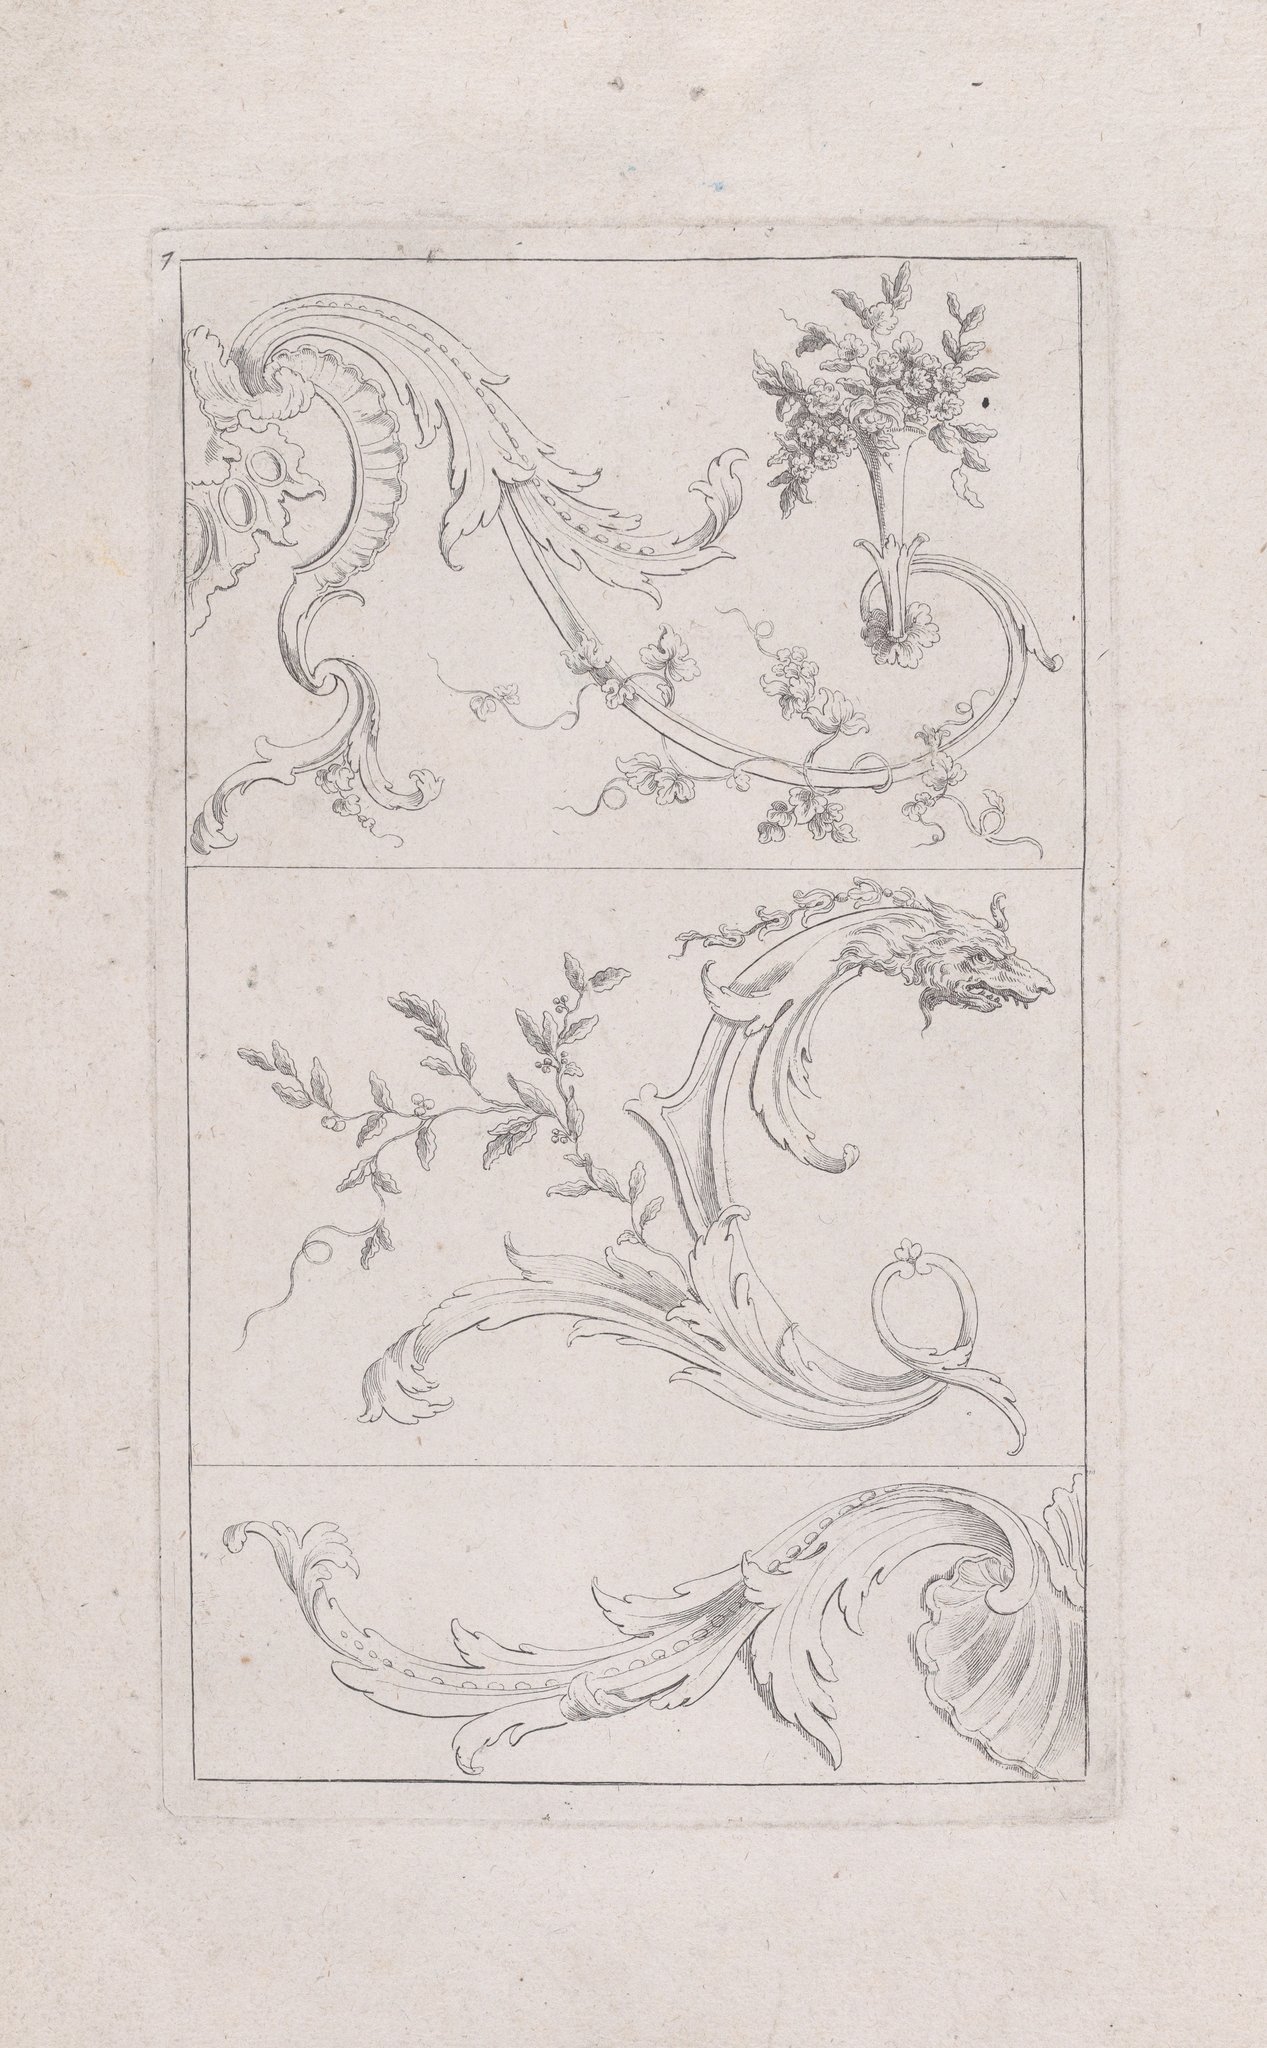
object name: print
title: Plate 7, from "Livre Nouveau de Prinsipes D'Ornemens, tres facil. Pour apprendre a Dessigner"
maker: nicolas guérard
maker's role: artist and publisher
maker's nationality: french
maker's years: 1648-1719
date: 1715-1725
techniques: engraving